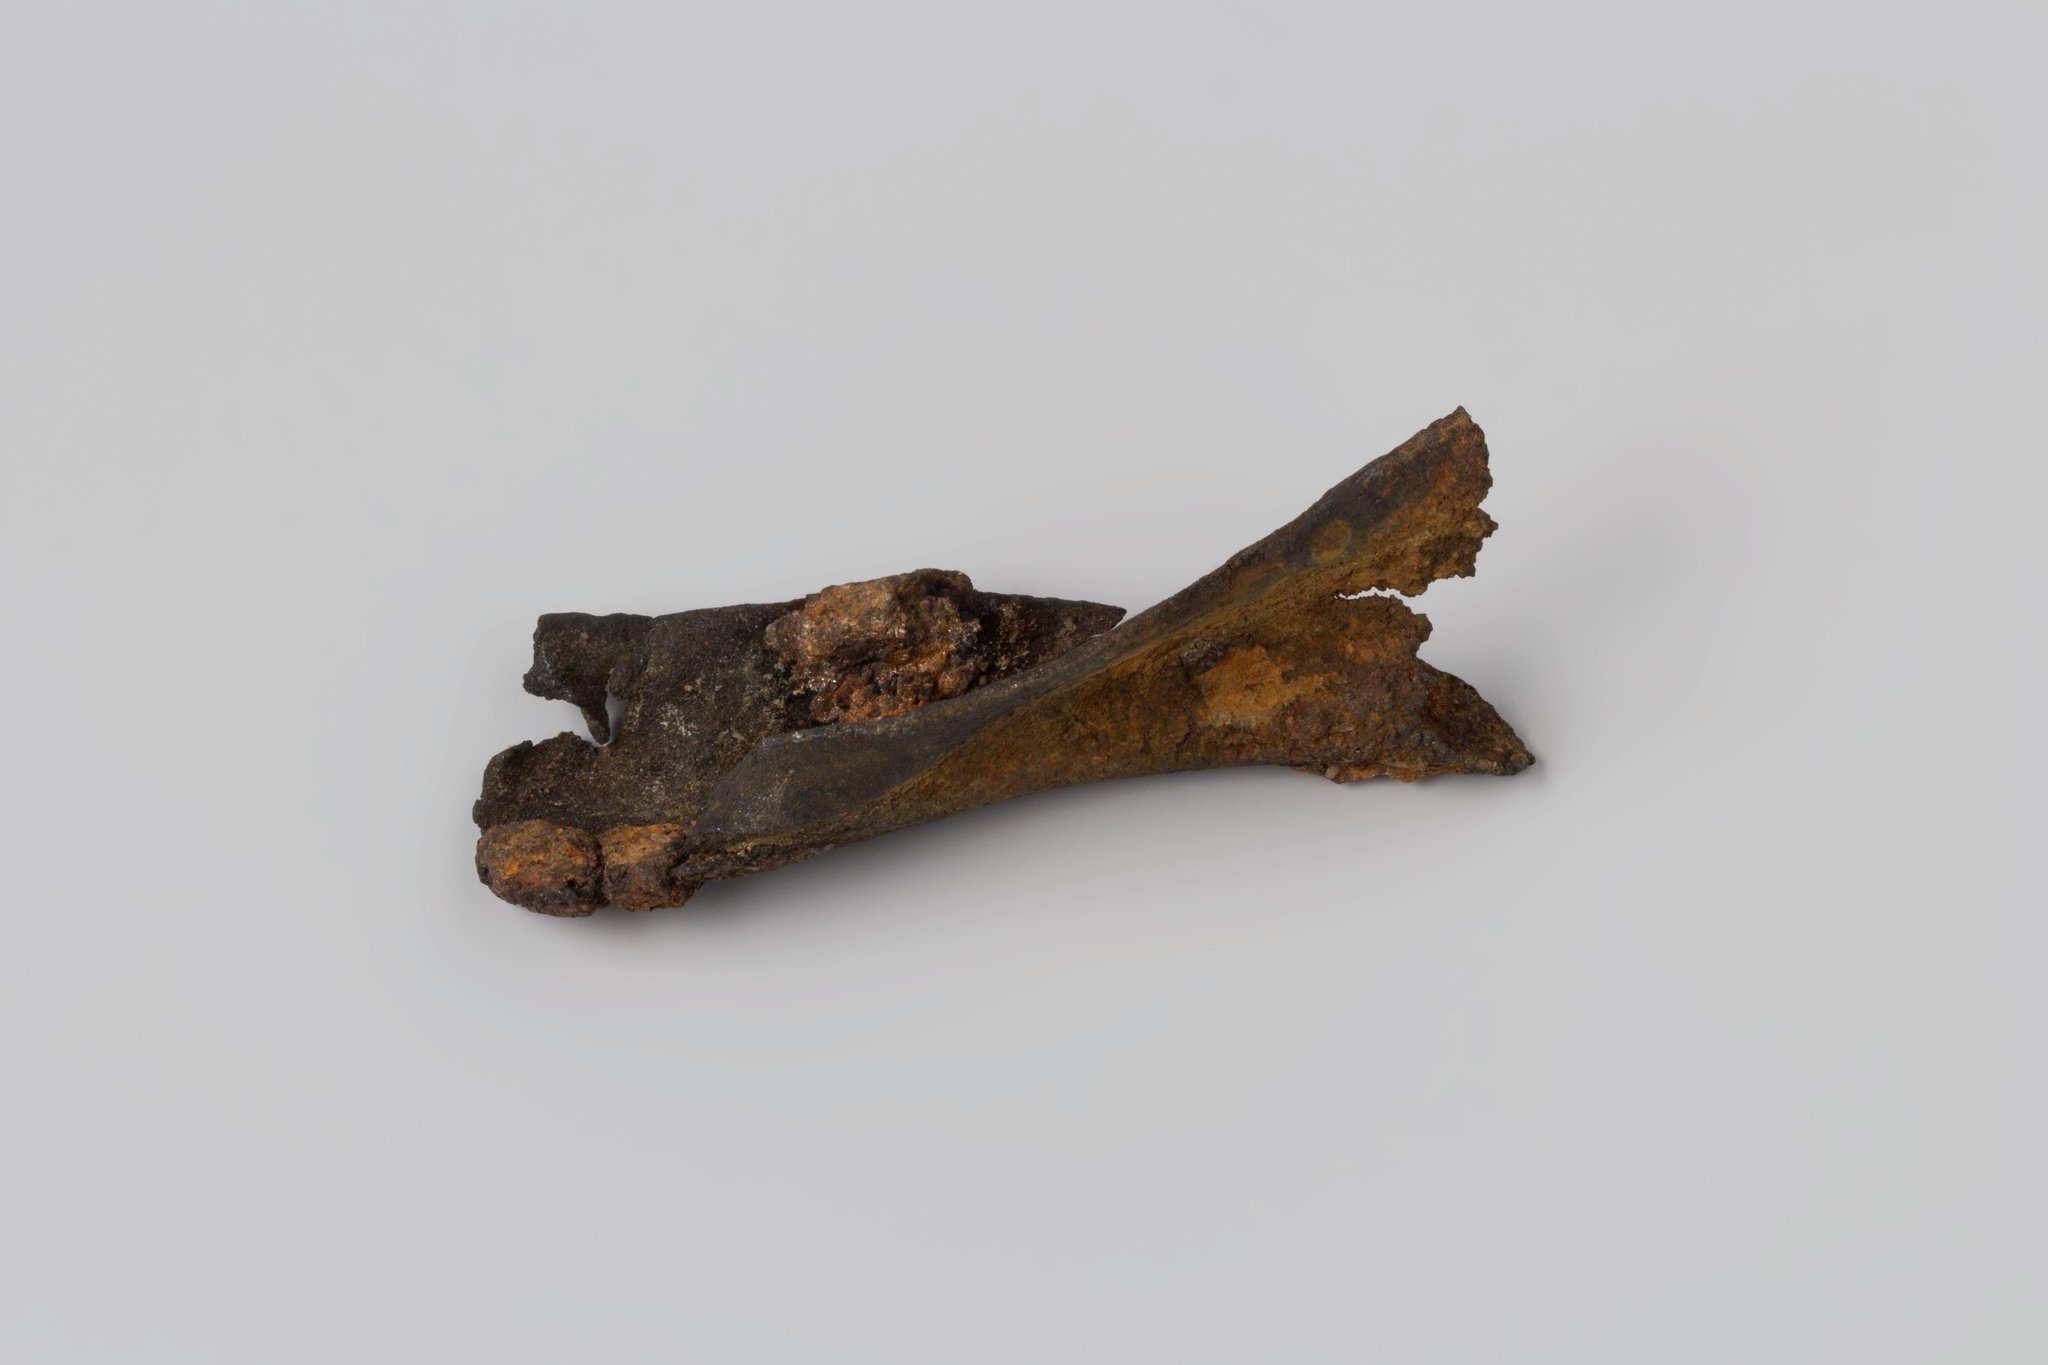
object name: scheepswrakvondst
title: Fragment van koper uit het wrak van de Oost-Indiëvaarder Hollandia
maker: Anonymous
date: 1700-1743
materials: copper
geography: netherlands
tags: verenigde oostindische compagnie, hollandia (schip), annet